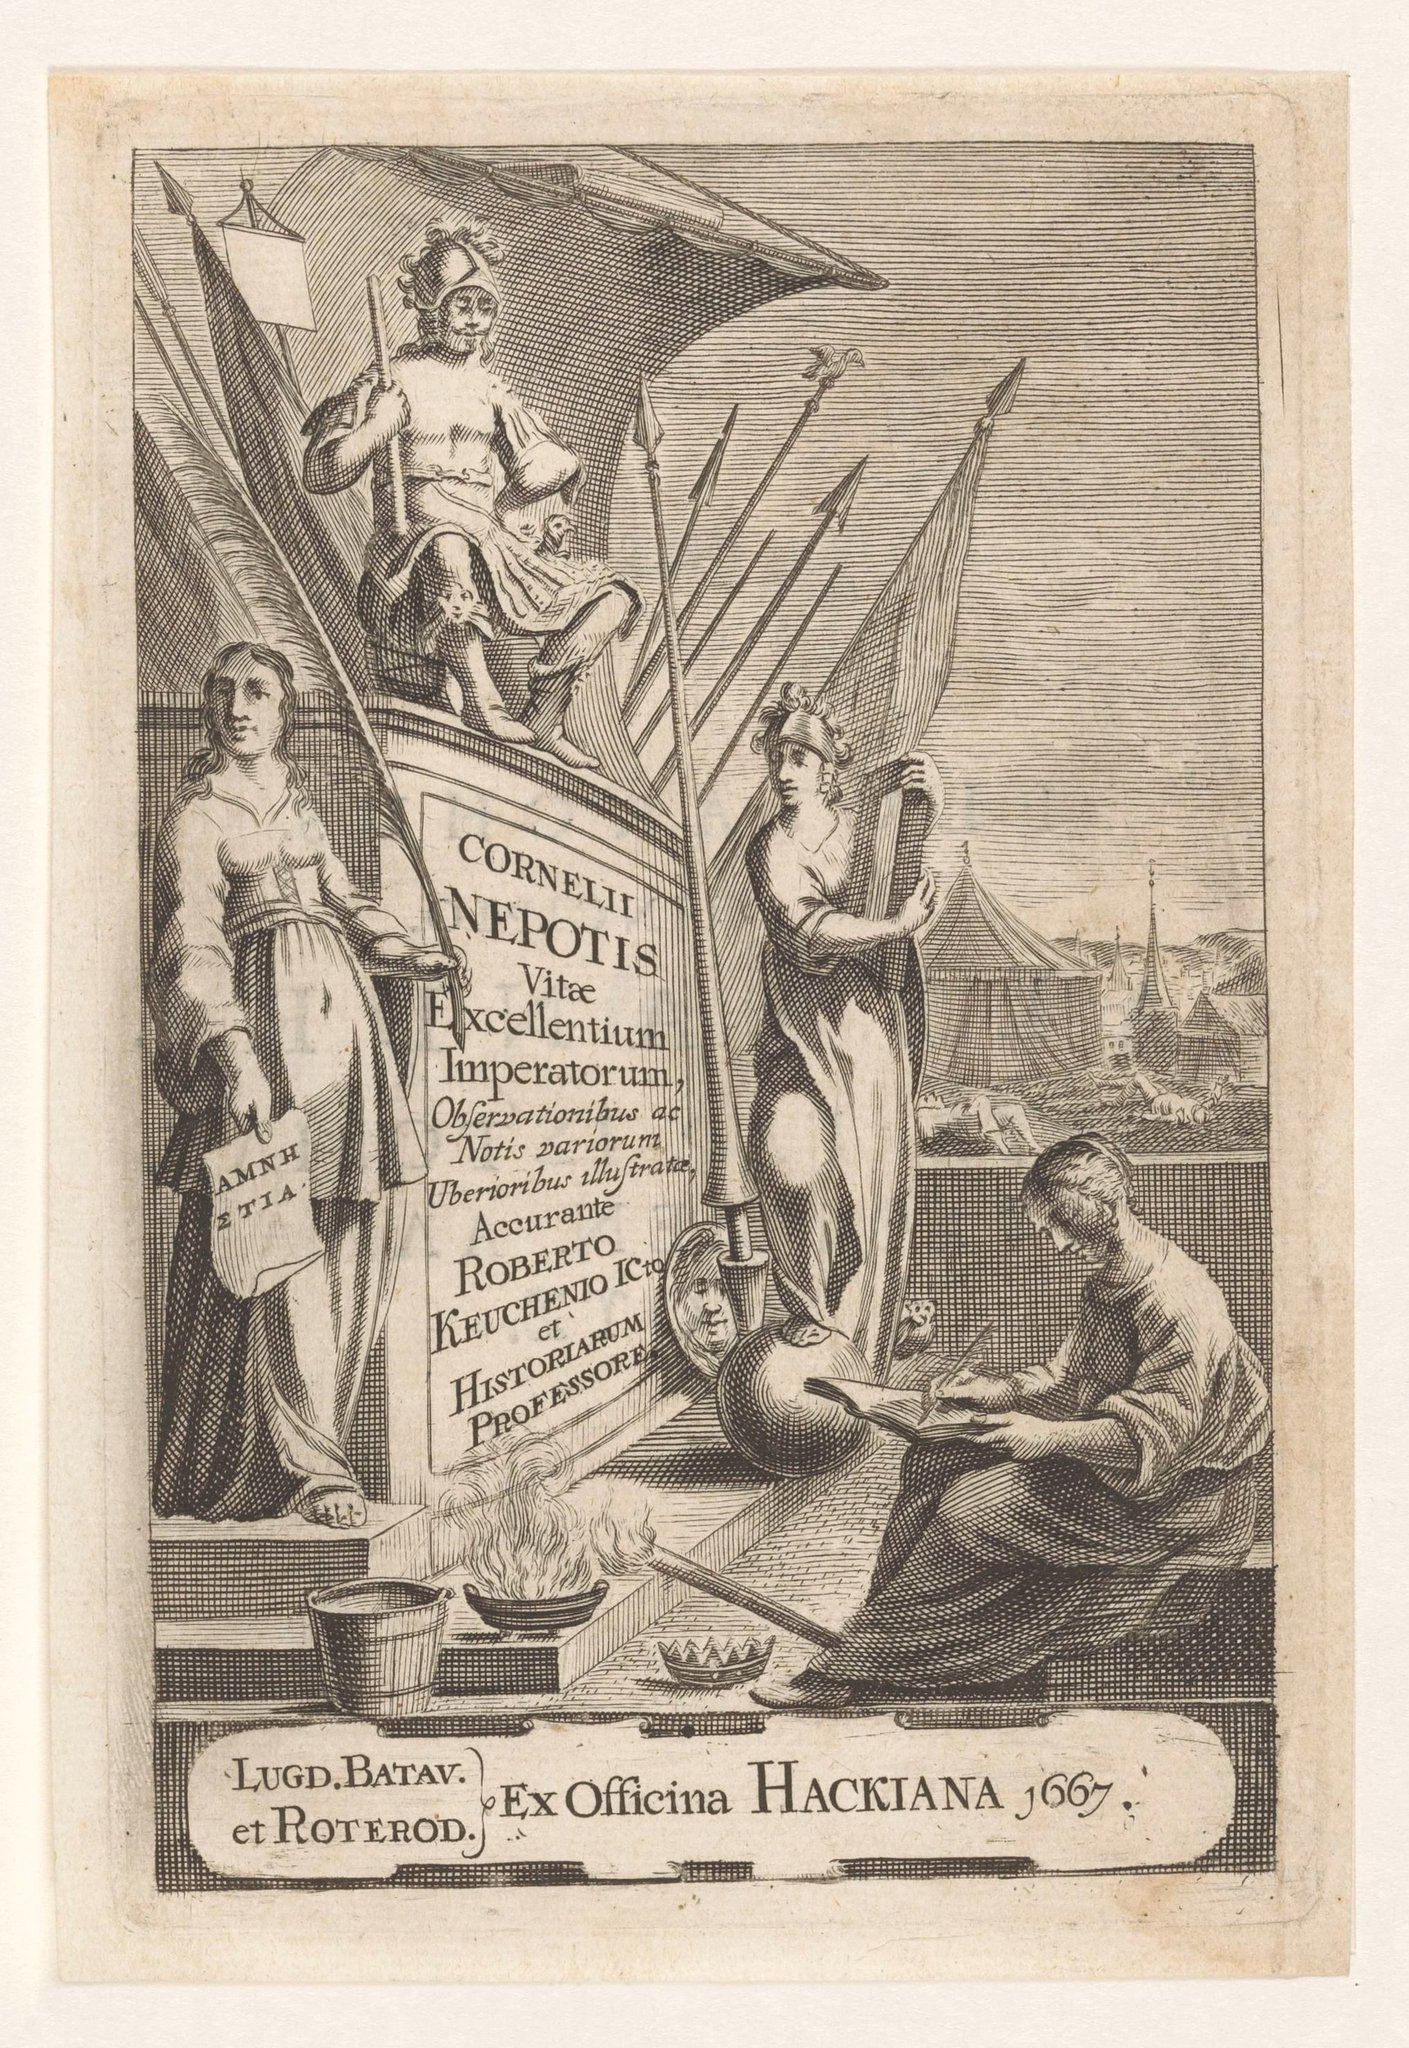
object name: titelblad, titelpagina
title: Titelpagina voor: Cornelius Nepos, Vitae Excellentium Imperatorum, 1667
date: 1667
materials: paper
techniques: engraving, etching, letterpress printing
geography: leiden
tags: sitting figure, (story of) minerva (pallas, athena), forgetfulness, 'historia'; 'historia' (ripa)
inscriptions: collector's mark: Lugt 2760, collector's mark: Lugt 2228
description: Een man met commandostaf in harnas zit omringd door vlaggen en speren op een voetstuk met de titel van het boek. Minerva en de personificatie van vergetelheid flankeren hem. Rechts schrijft Geschiedenis in een boek.